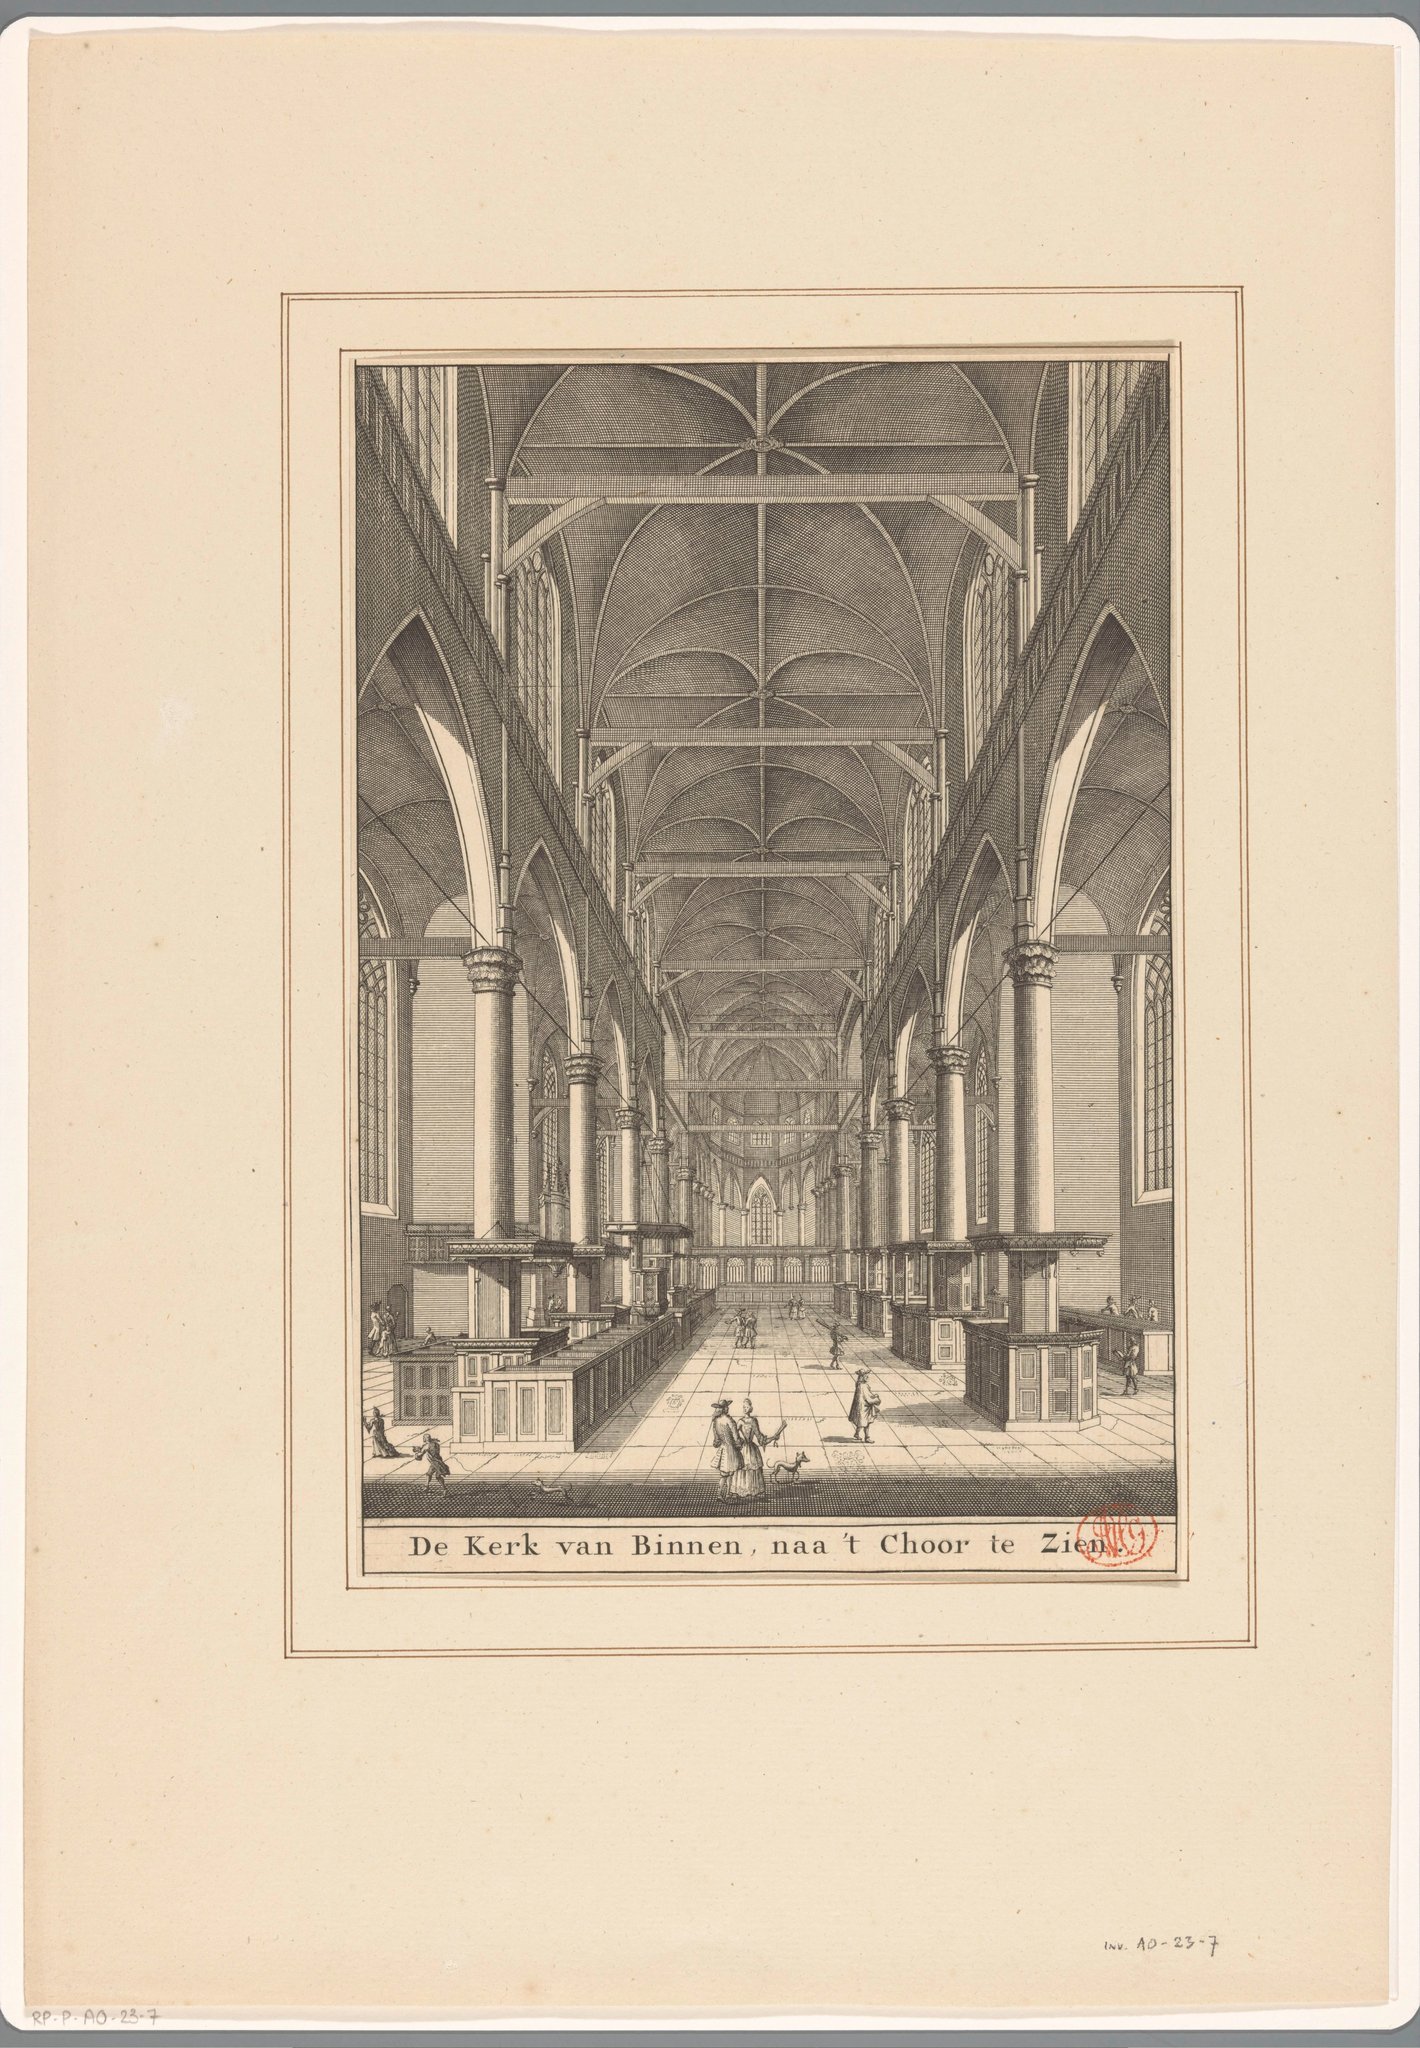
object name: print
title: Interieur van de Oude Kerk te Amsterdam, gezien richting het koor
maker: daniël stopendaal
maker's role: print maker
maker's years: 1672-1726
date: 1685-1726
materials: paper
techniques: engraving, etching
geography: amsterdam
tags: parts of church interior, parts of church interior: choir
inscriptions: collector's mark: Lugt 195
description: Is waarschijnlijk oorspronkelijk één van de randprenten van 'Caart vande Sitplaat-zen inde Oude-Kerk', een plattegrond van de zitplaatsen in de Oude Kerk. Daniël Stopendaal staat als prentmaker vermeld op de plattegrond zelf, de randprenten zijn mogelijk ook door hem gemaakt. Zie RP-P-AO-23-6-1, RP-P-AO-23-6-2 en RP-P-AO-23-8 voor andere bijhorende randprenten. Zie RP-P-AO-23-57 voor een soortgelijke plattegrond van de Oosterkerk met randprenten.